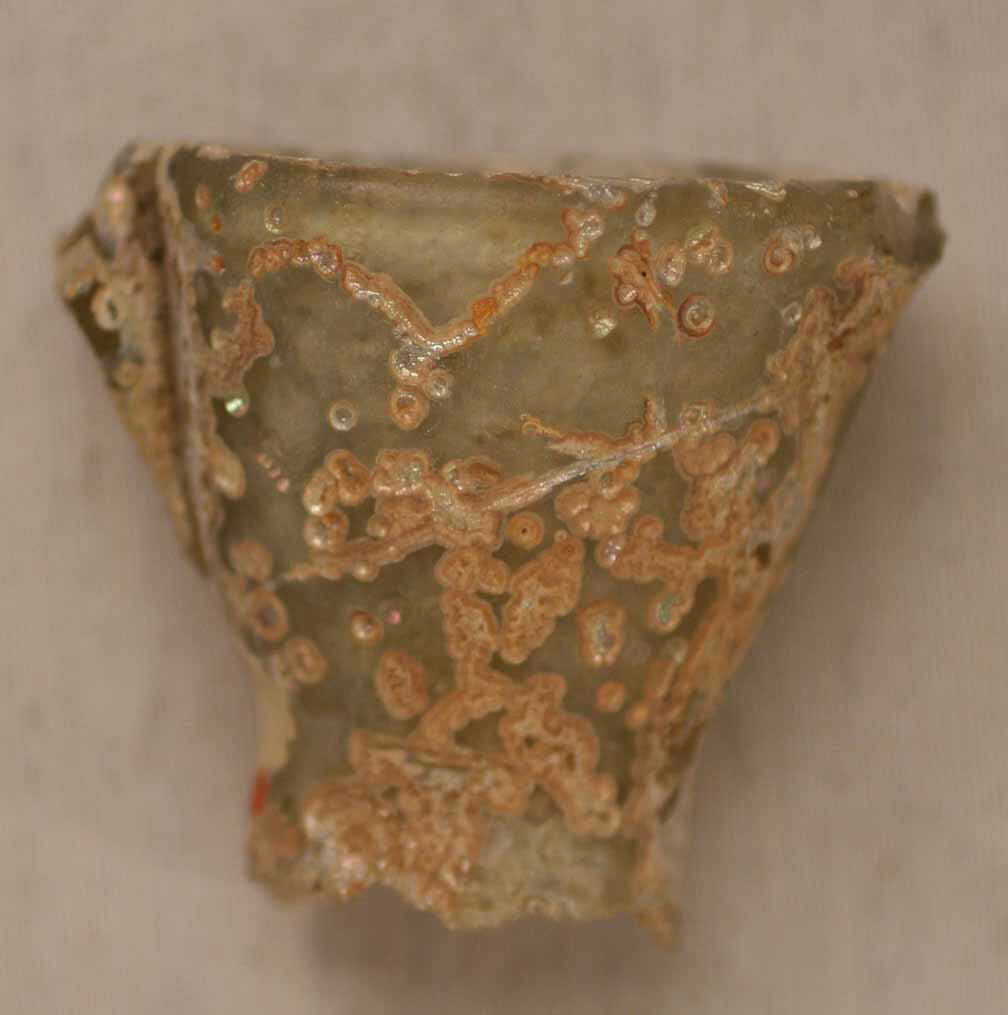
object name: fragment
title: Fragment of an Ewer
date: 701-900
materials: glass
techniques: glassblowing, tooling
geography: iraq